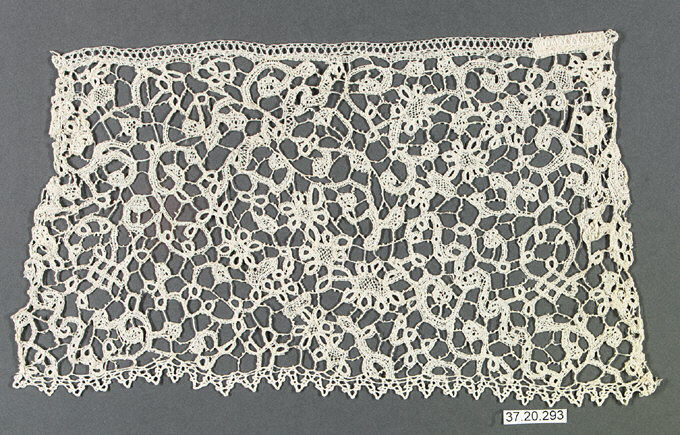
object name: fragment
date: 1601-1700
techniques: lace